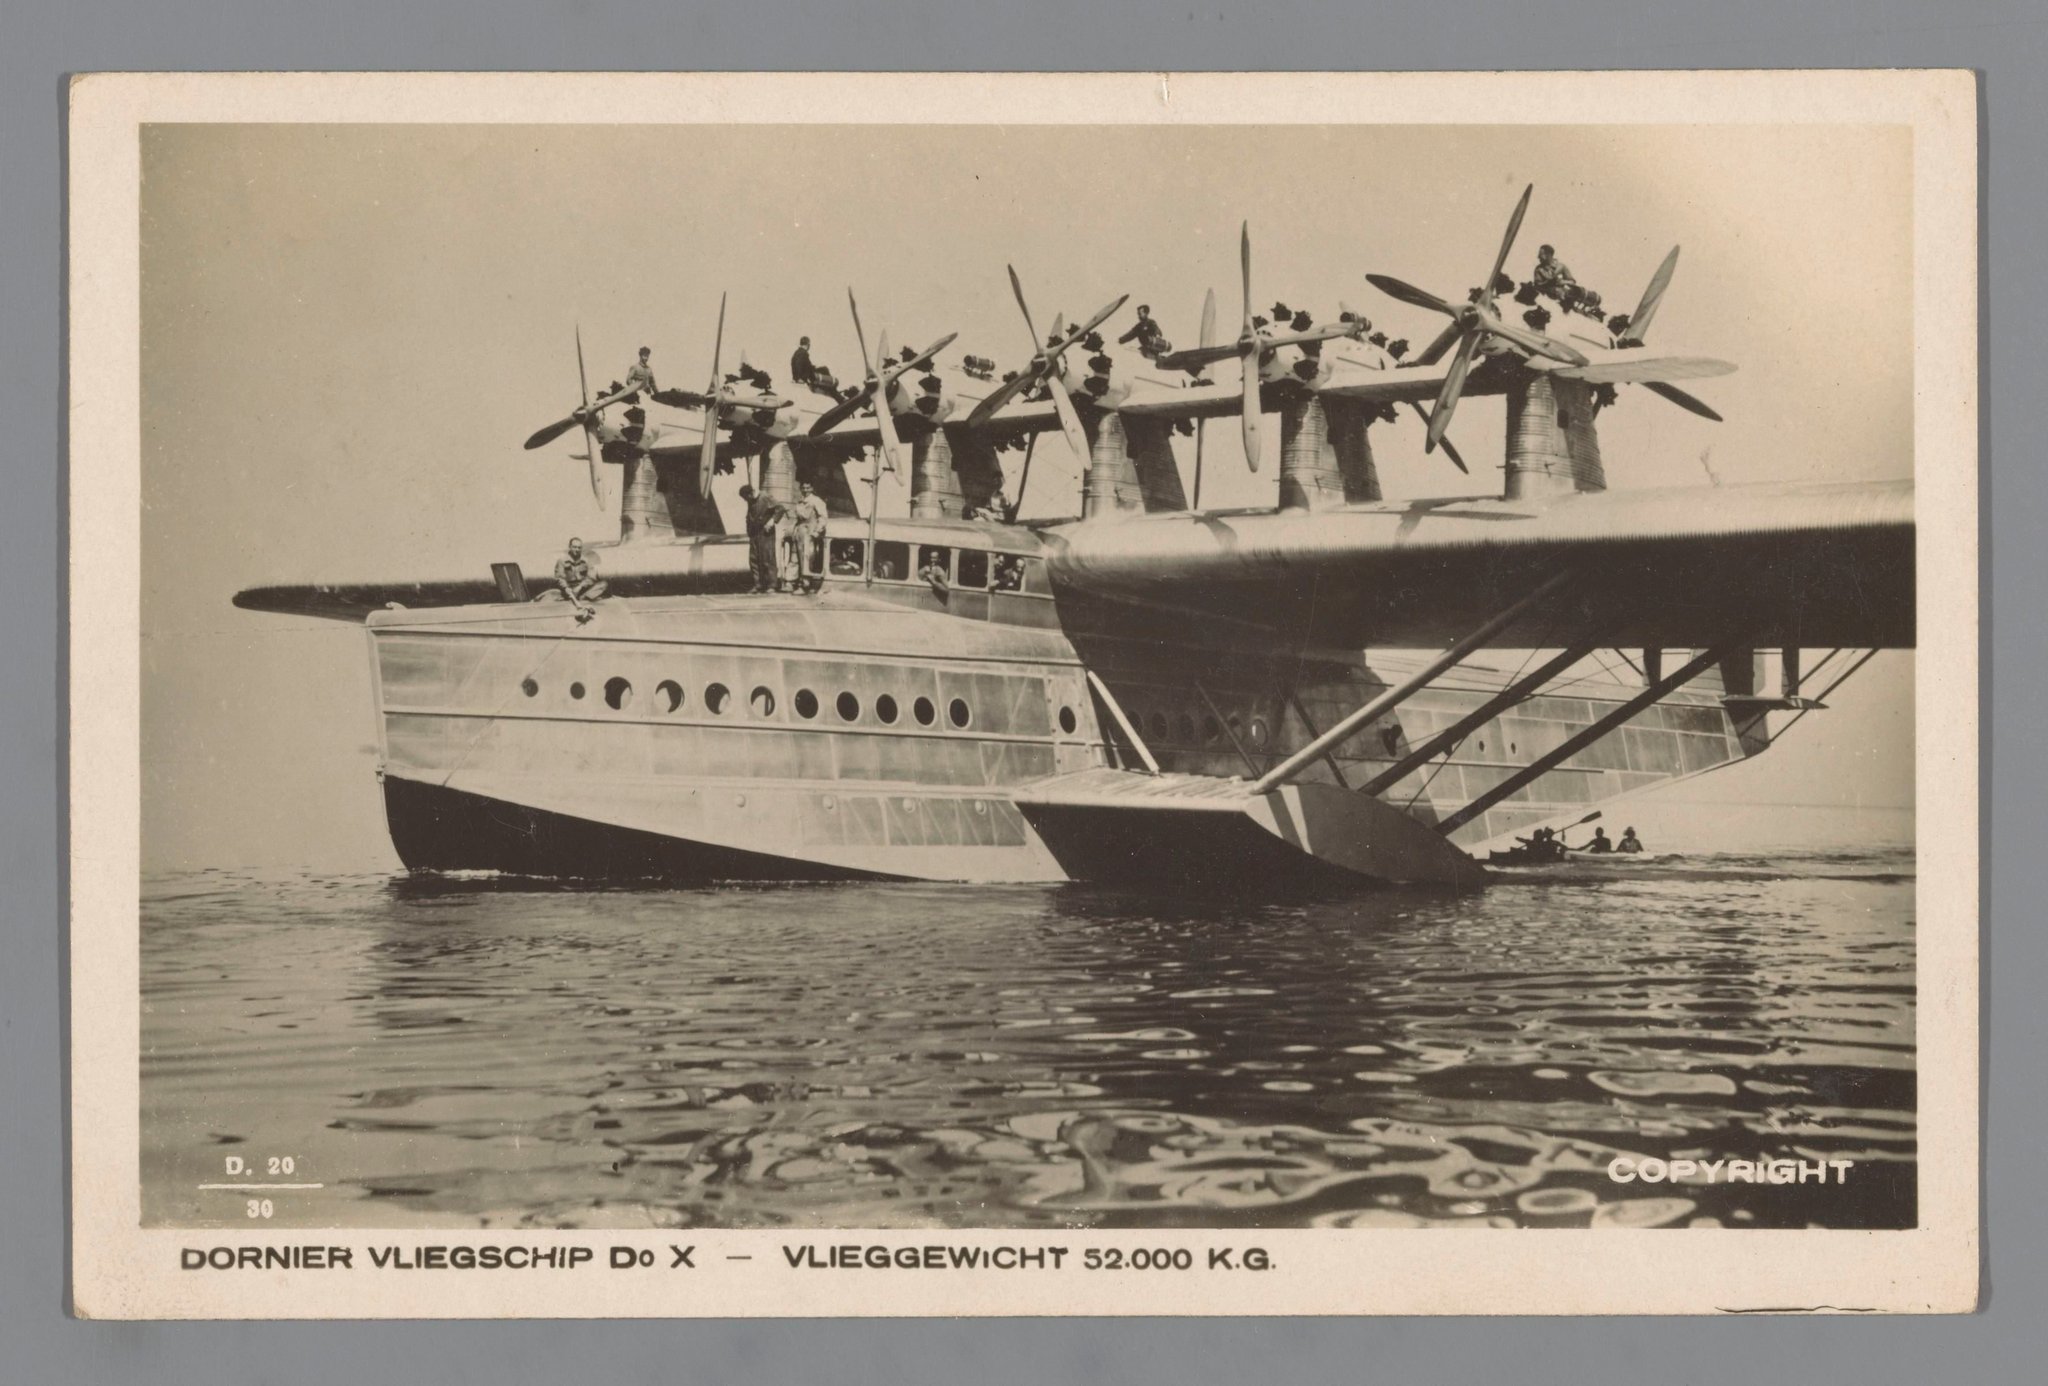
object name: photograph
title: Watervliegtuig Dornier Do X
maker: Anonymous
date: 1925-1935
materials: photographic support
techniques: gelatin silver print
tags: aircraft, aeroplane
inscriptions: inscription: ‘D. 20 30’, inscription: ‘Copyright Koninklijke Luchtvaart Maatschappij Fototechnische Dienst Rotterdam’